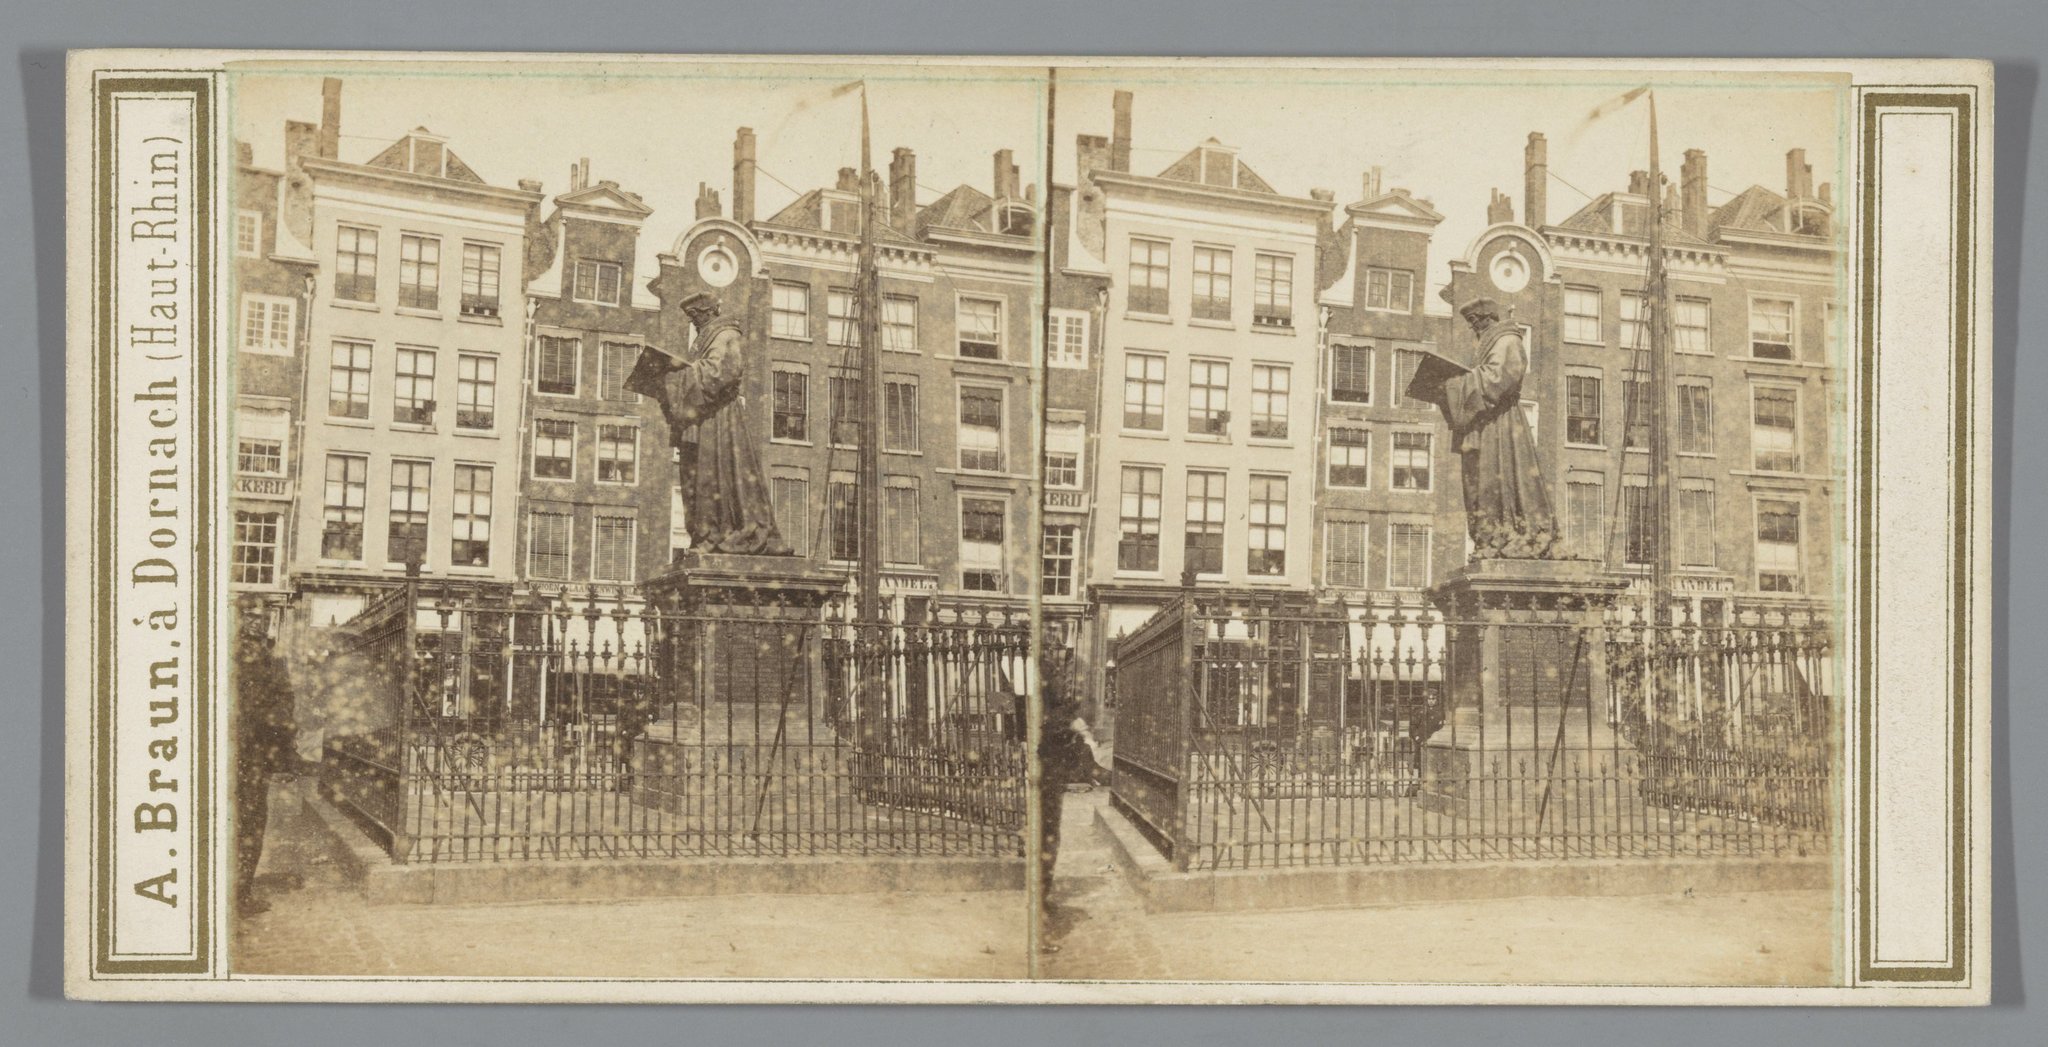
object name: stereograph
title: Rotterdam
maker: Anonymous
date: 1860-1866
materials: cardboard, paper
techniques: albumen print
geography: grotemarkt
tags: desiderius erasmus, monument, statue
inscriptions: inscription: ‘[...]’, number: ‘No 3832’